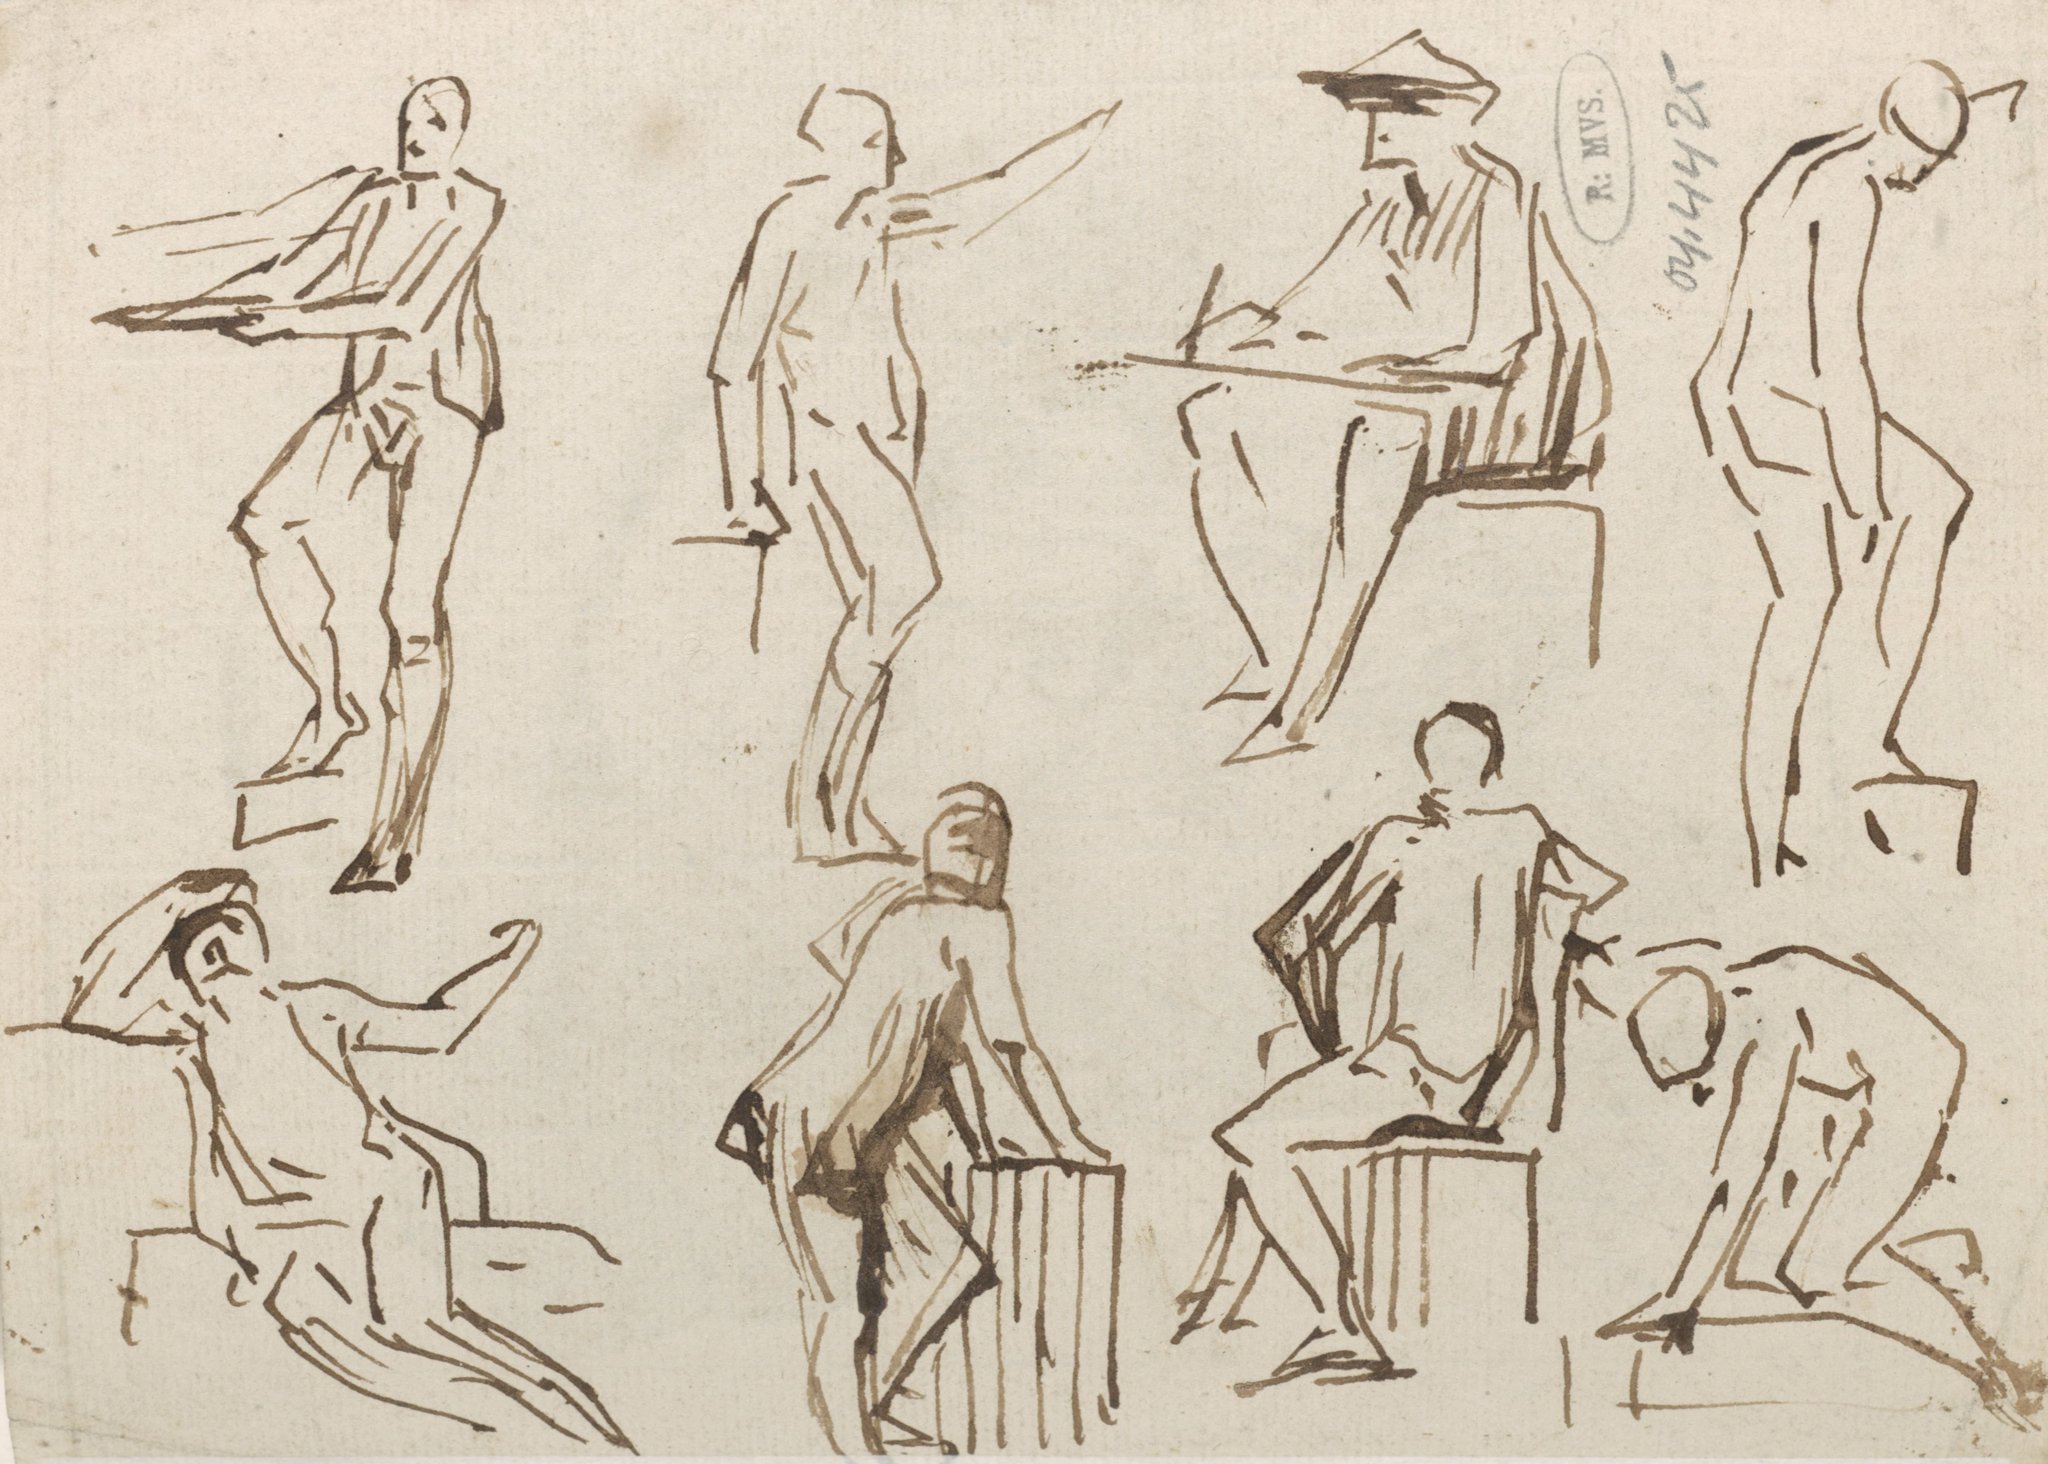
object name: drawing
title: Studies van het menselijk lichaam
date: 1710-1767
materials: ink, paper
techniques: pen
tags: movements of the human body (+ positions (of the human figure))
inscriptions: collector's mark: Lugt 2228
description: Acht studies van het menselijk lichaam in verschillende poses, onder andere zittend en staand met een gebogen knie.